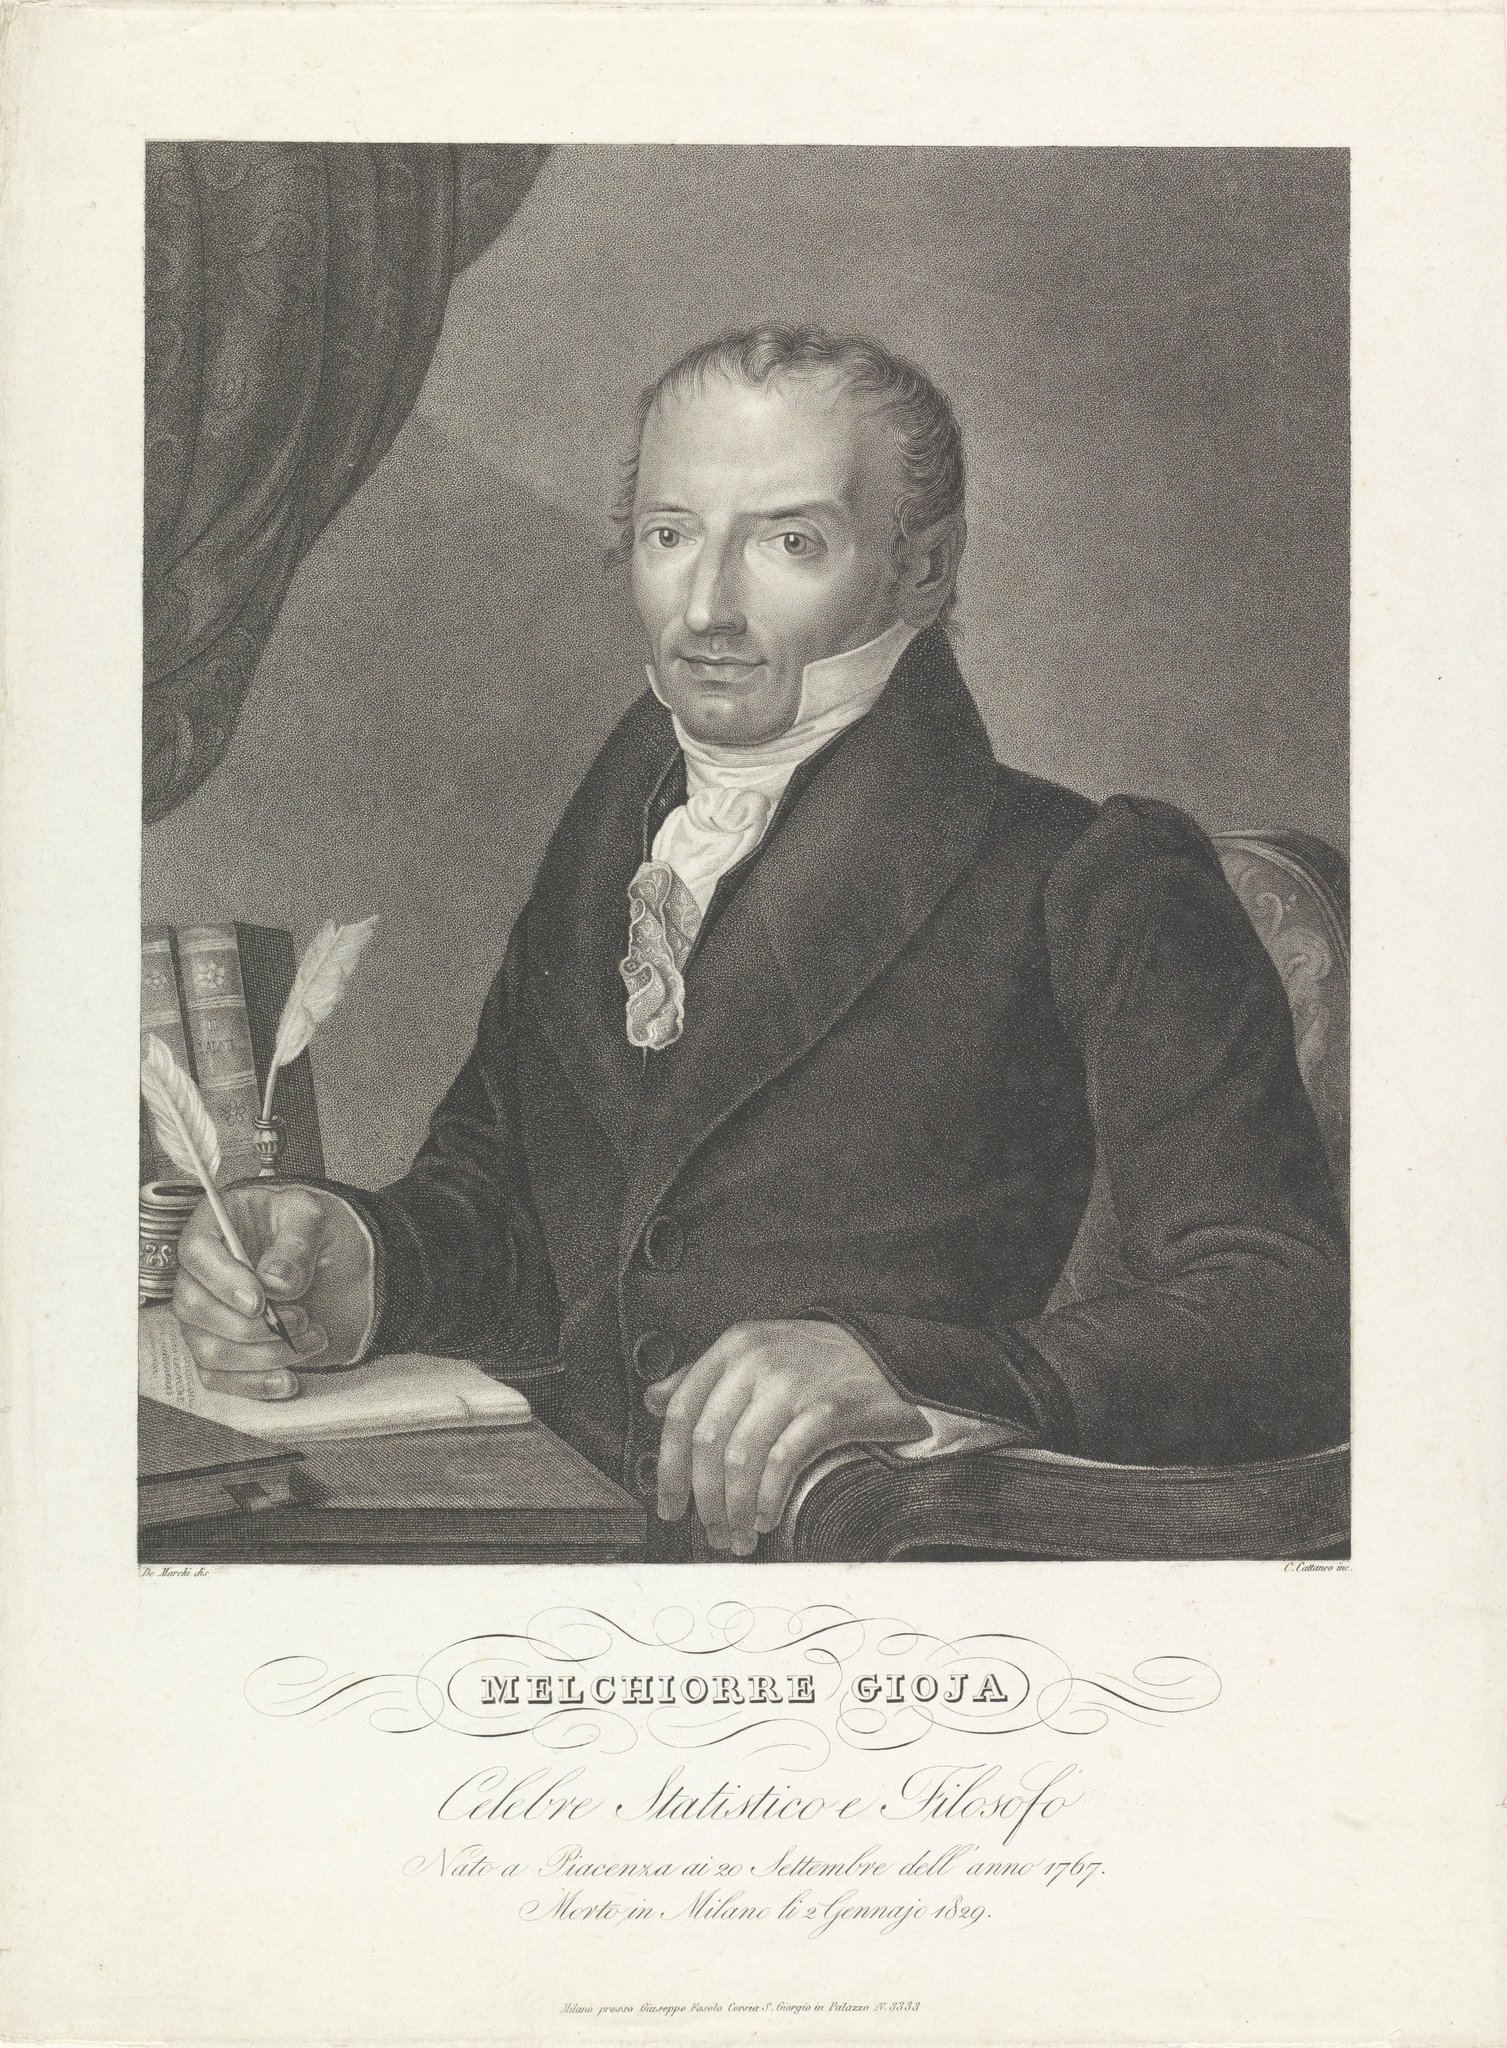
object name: print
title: Portret van schrijver Melchiorre Gioia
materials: paper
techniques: stippling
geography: italy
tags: historical persons, writer, poet, author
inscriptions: collector's mark: Lugt 2228